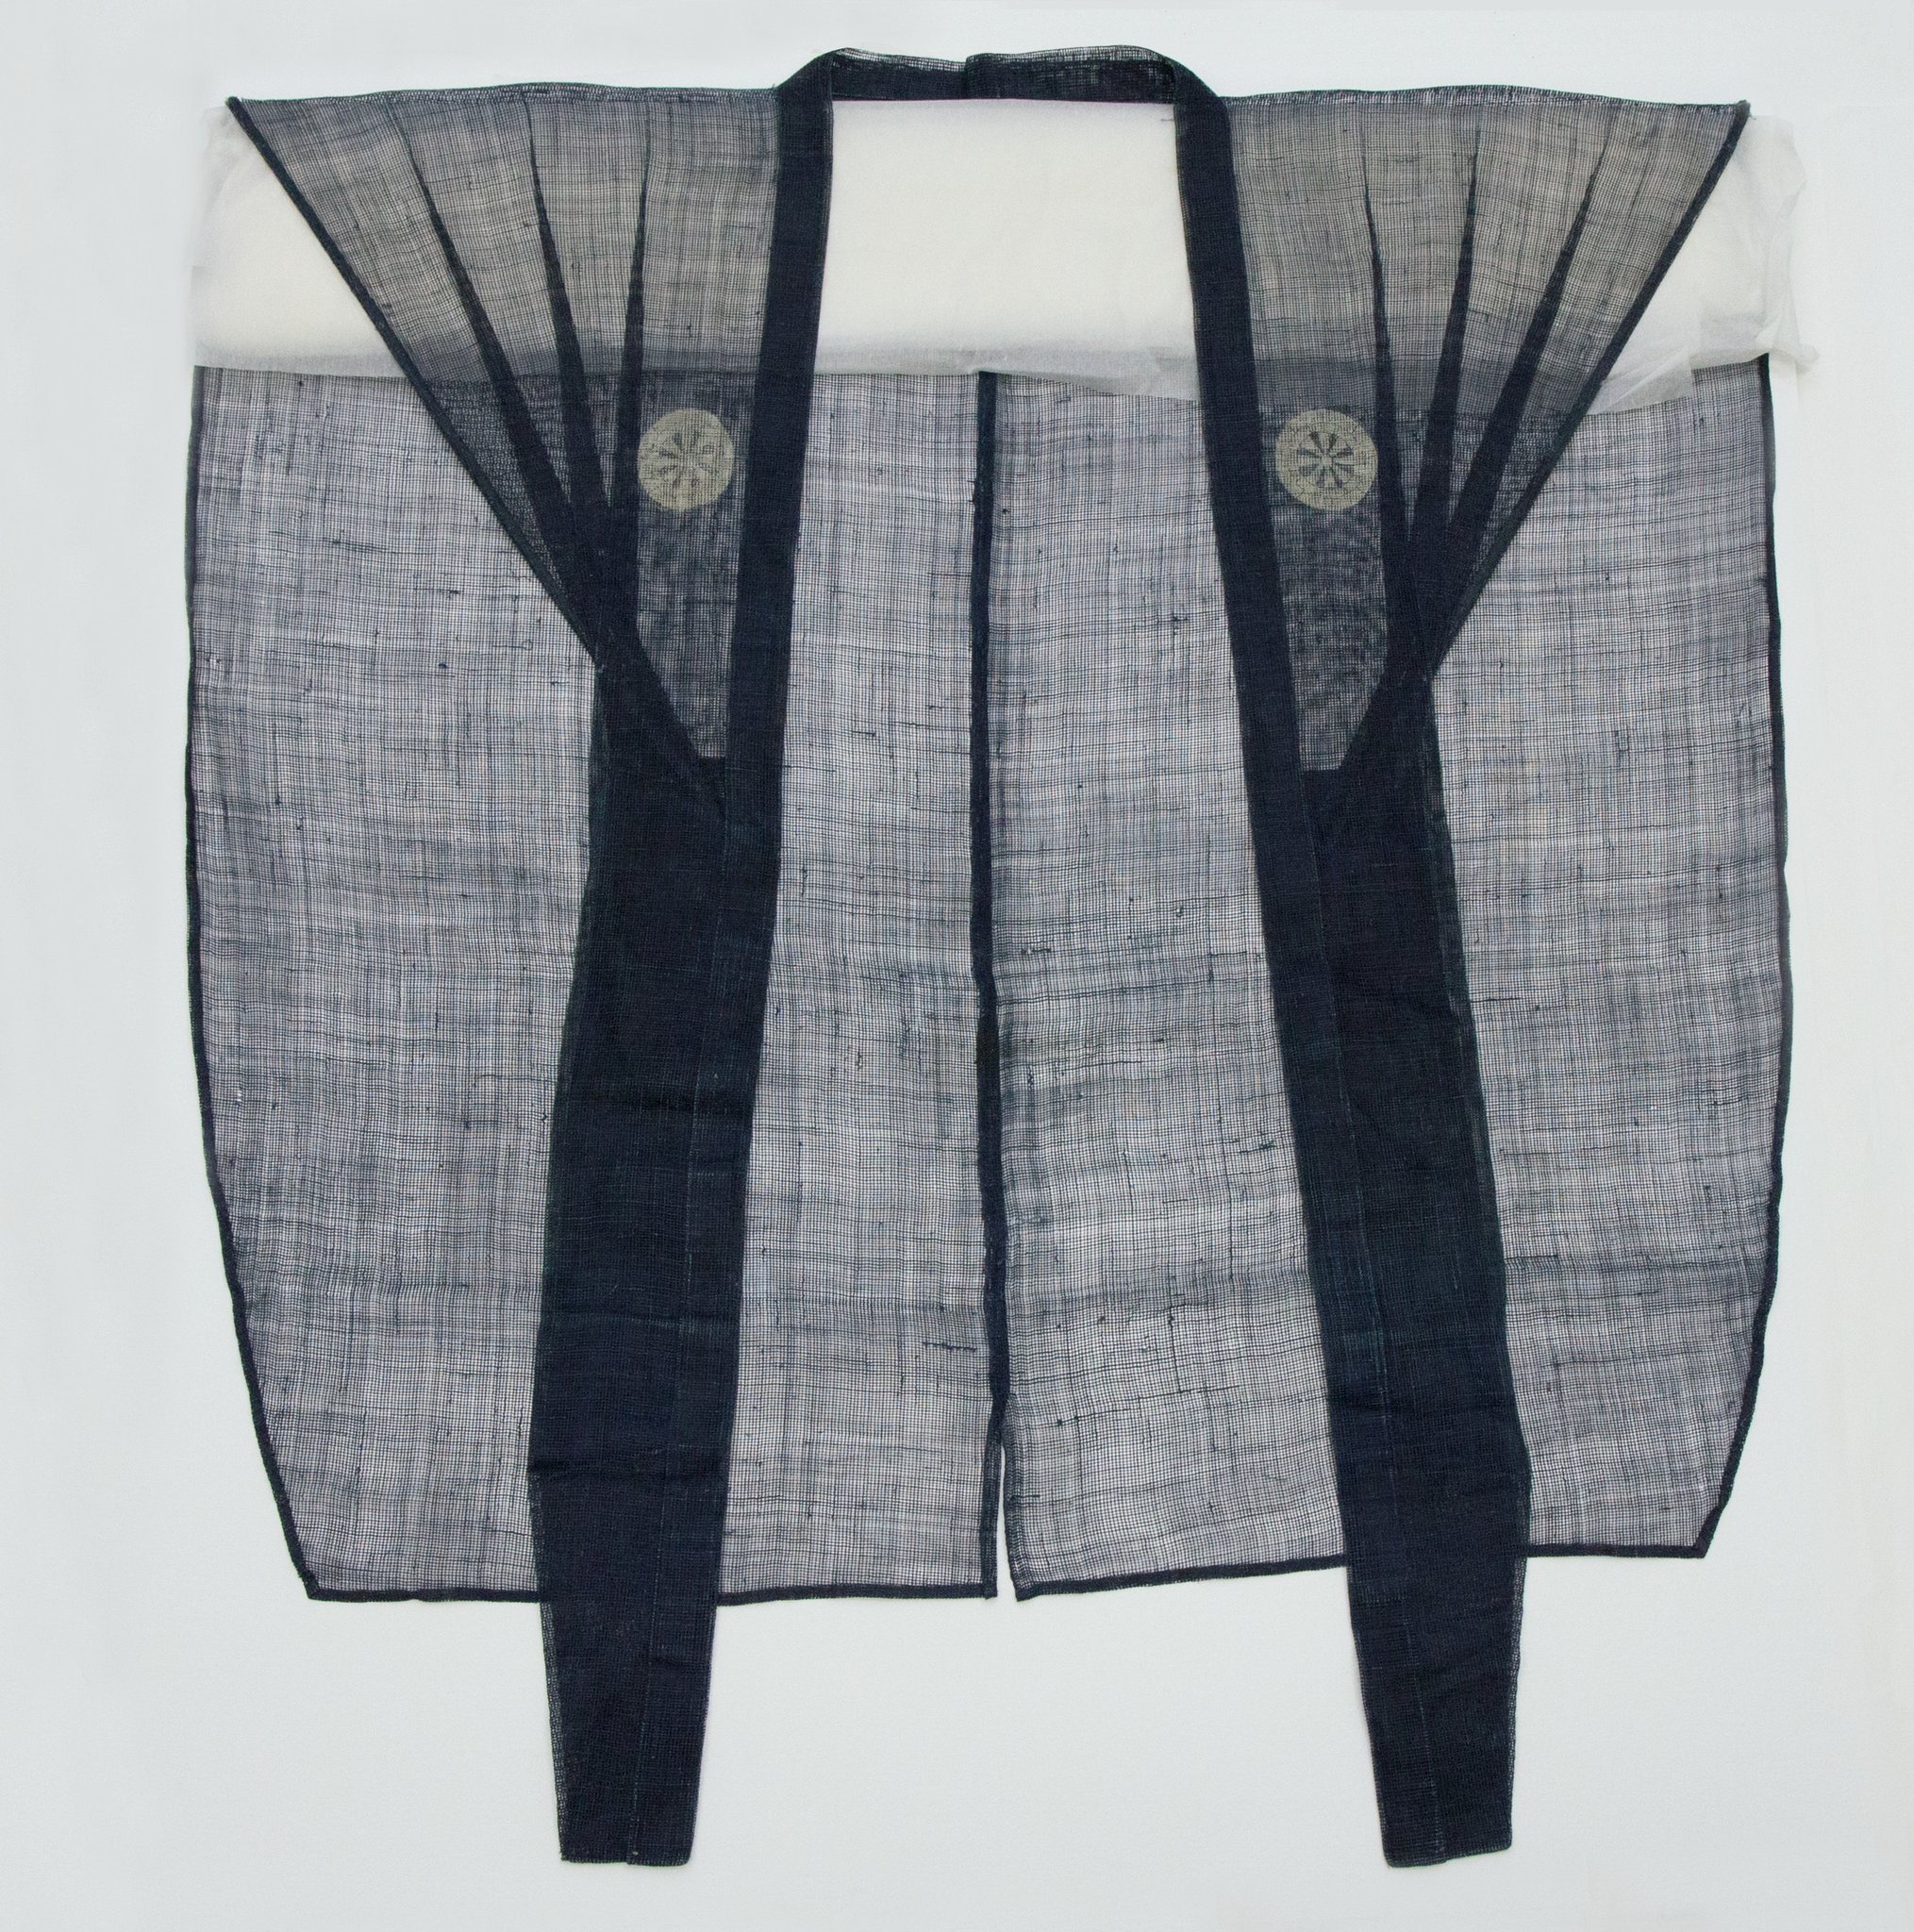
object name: overvest kataginu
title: Overvest (kataginu)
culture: japanese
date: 1615-1868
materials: dye, textile